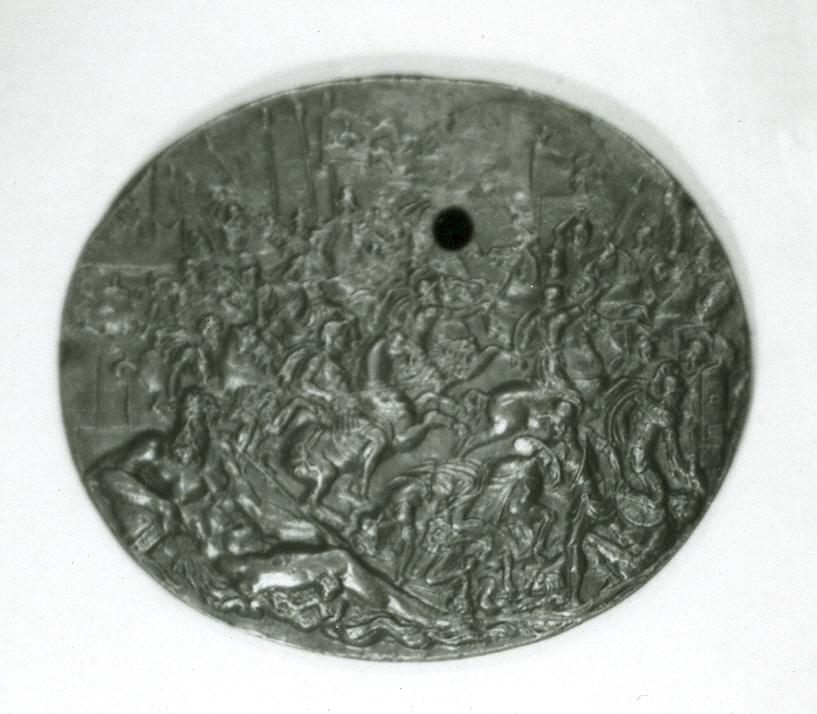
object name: plaquette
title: Battle Scene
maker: giovanni bernardi da castel bolognese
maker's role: artist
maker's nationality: italian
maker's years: 1494-1553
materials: copper alloy, patina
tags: battles,horses